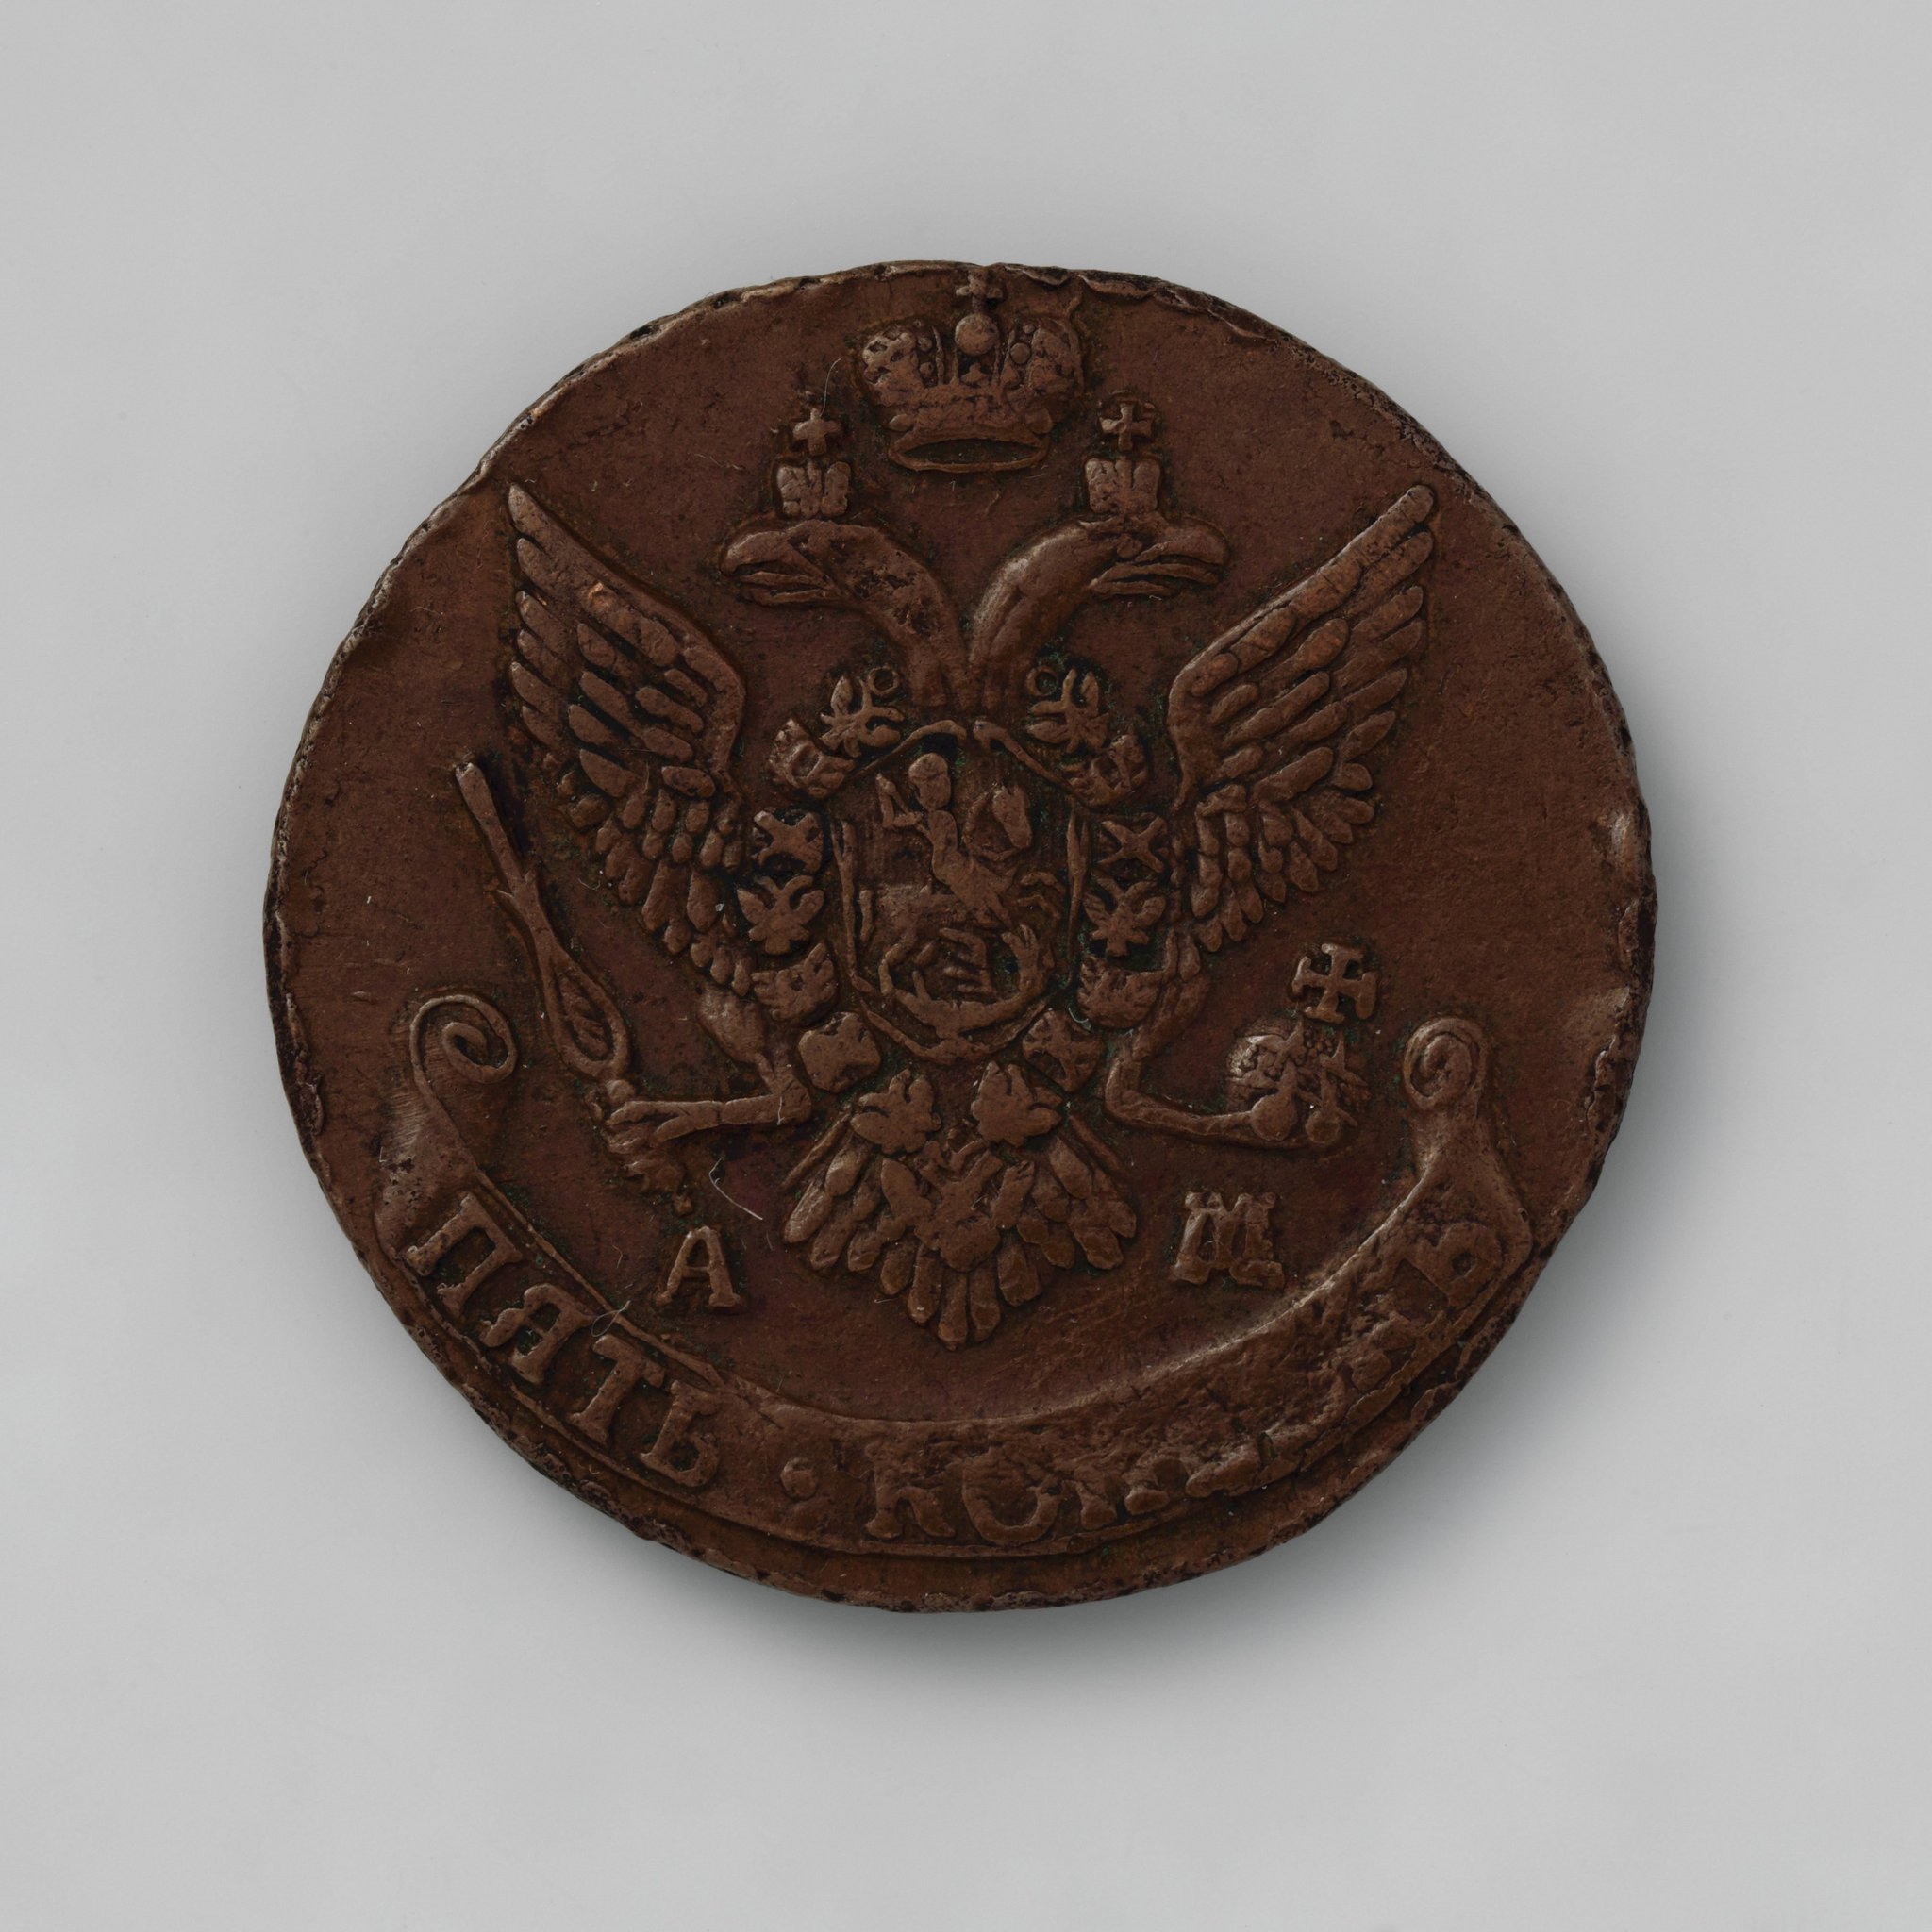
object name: coin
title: Rusland, czarina Catherina II, 5 kopeken of piatak,1793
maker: Anonymous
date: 1793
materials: copper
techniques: striking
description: Koperen munt. Voorzijde: binnen een krans van twee samengebonden takken tusen jaartyal gekrond mongam, bestaande uit de letters J en E, van de czarina. Keerzijde: dubbelkoppige adelaar met in de poten scepter en rijksappel. Op de borst een door ridderorde met juweel omhangen ovaal wapenschild en op beide koppen een kleine kroon, waarboven een grote kroon. Onder de adelaar de letters A en M van de munthuis te Annensk in Siberië. Kabelrand.